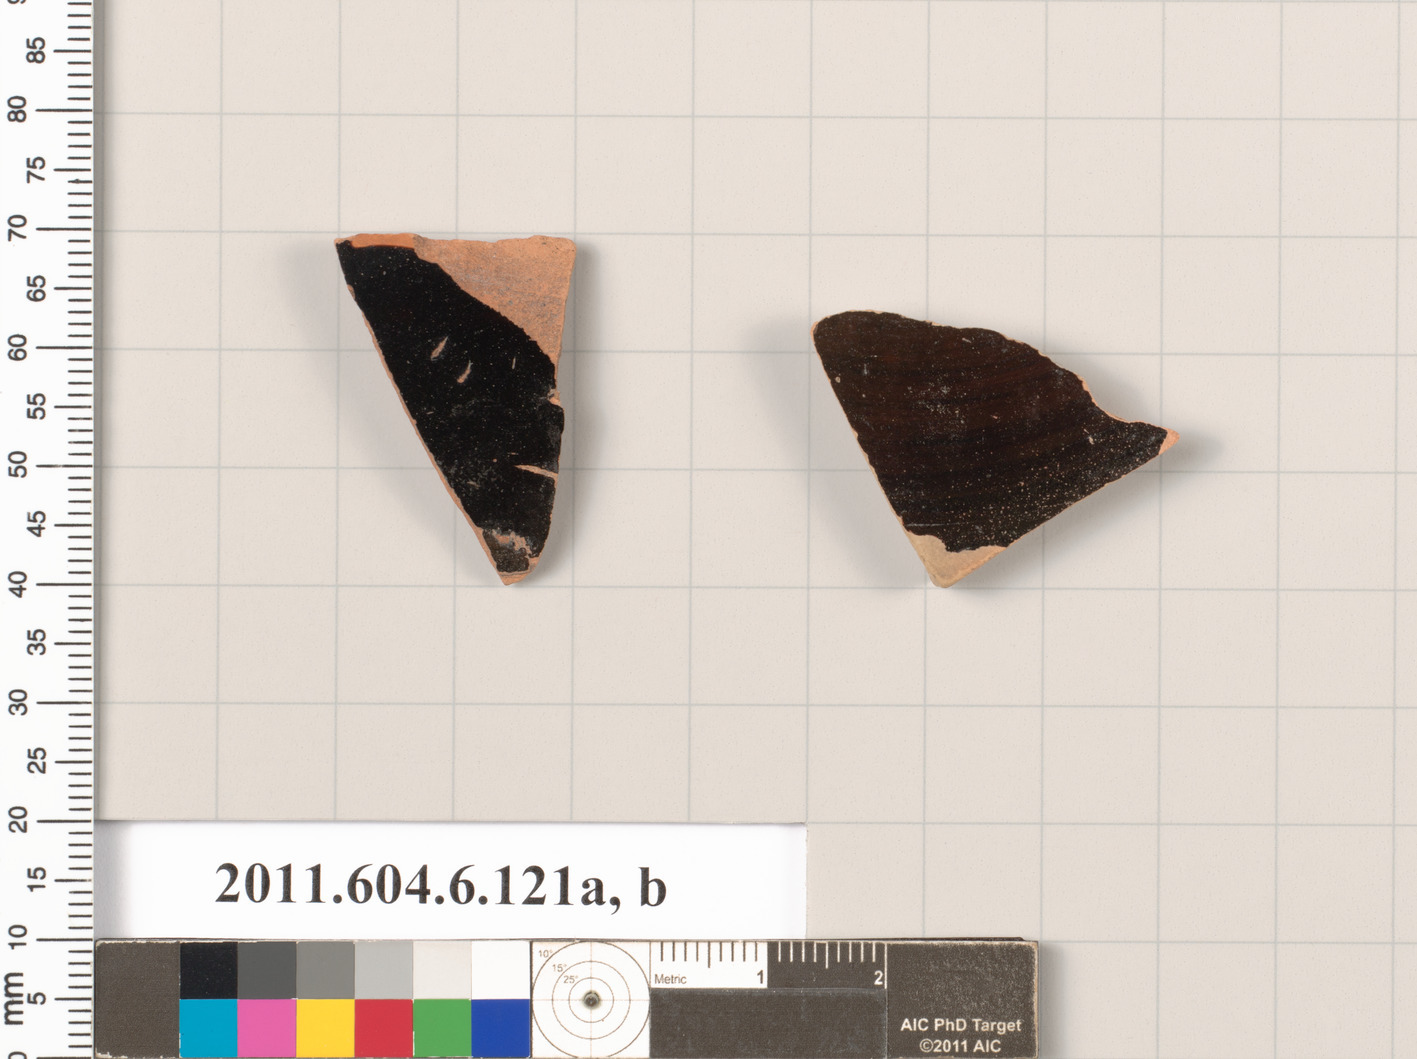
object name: undetermined closed shape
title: Terracotta fragments of closed shapes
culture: greek, attic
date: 600-401 BCE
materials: terracotta